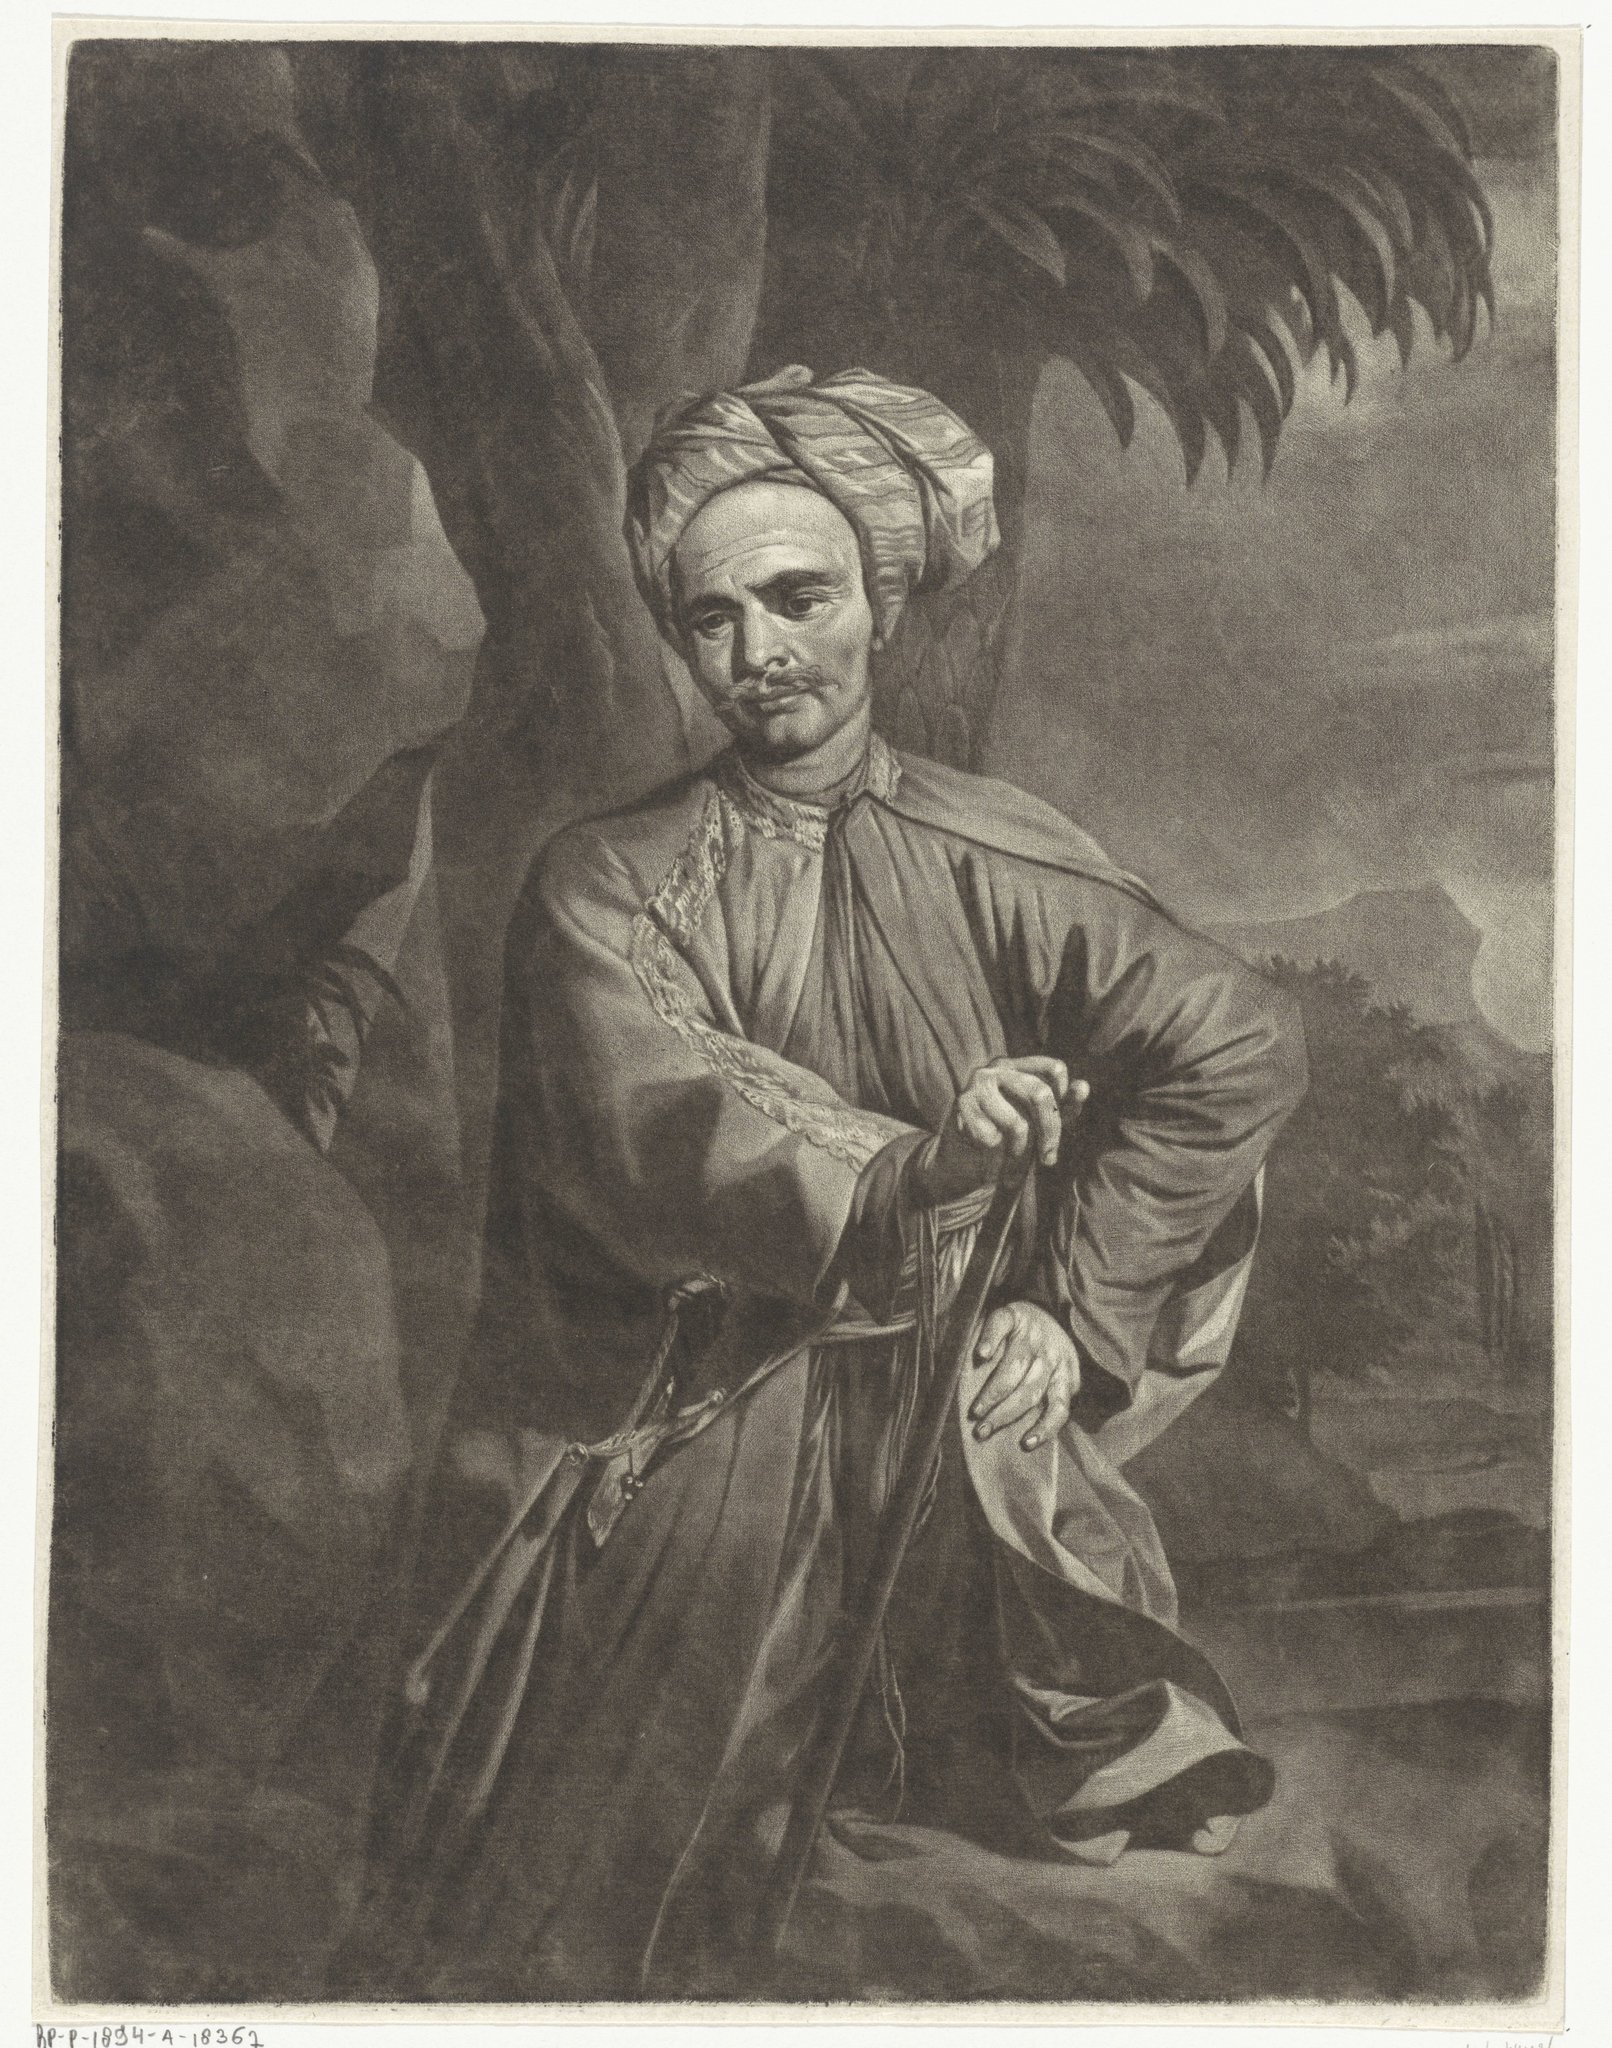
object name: print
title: Portret van een Oosterling met een tulband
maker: arnout rentinck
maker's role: draughtsman, print maker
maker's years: 1712-1774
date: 1722-1775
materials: paper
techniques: mezzotint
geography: amsterdam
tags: hacking and thrusting weapons: sword, head-gear: turban, trees: palm-tree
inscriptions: collector's mark: Lugt 2228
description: Onder een boom staat een man met een tulband, een zwaard en een staf. Hij staat naast een rotsformatie. Op de achtergrond rotsen en palmbomen.